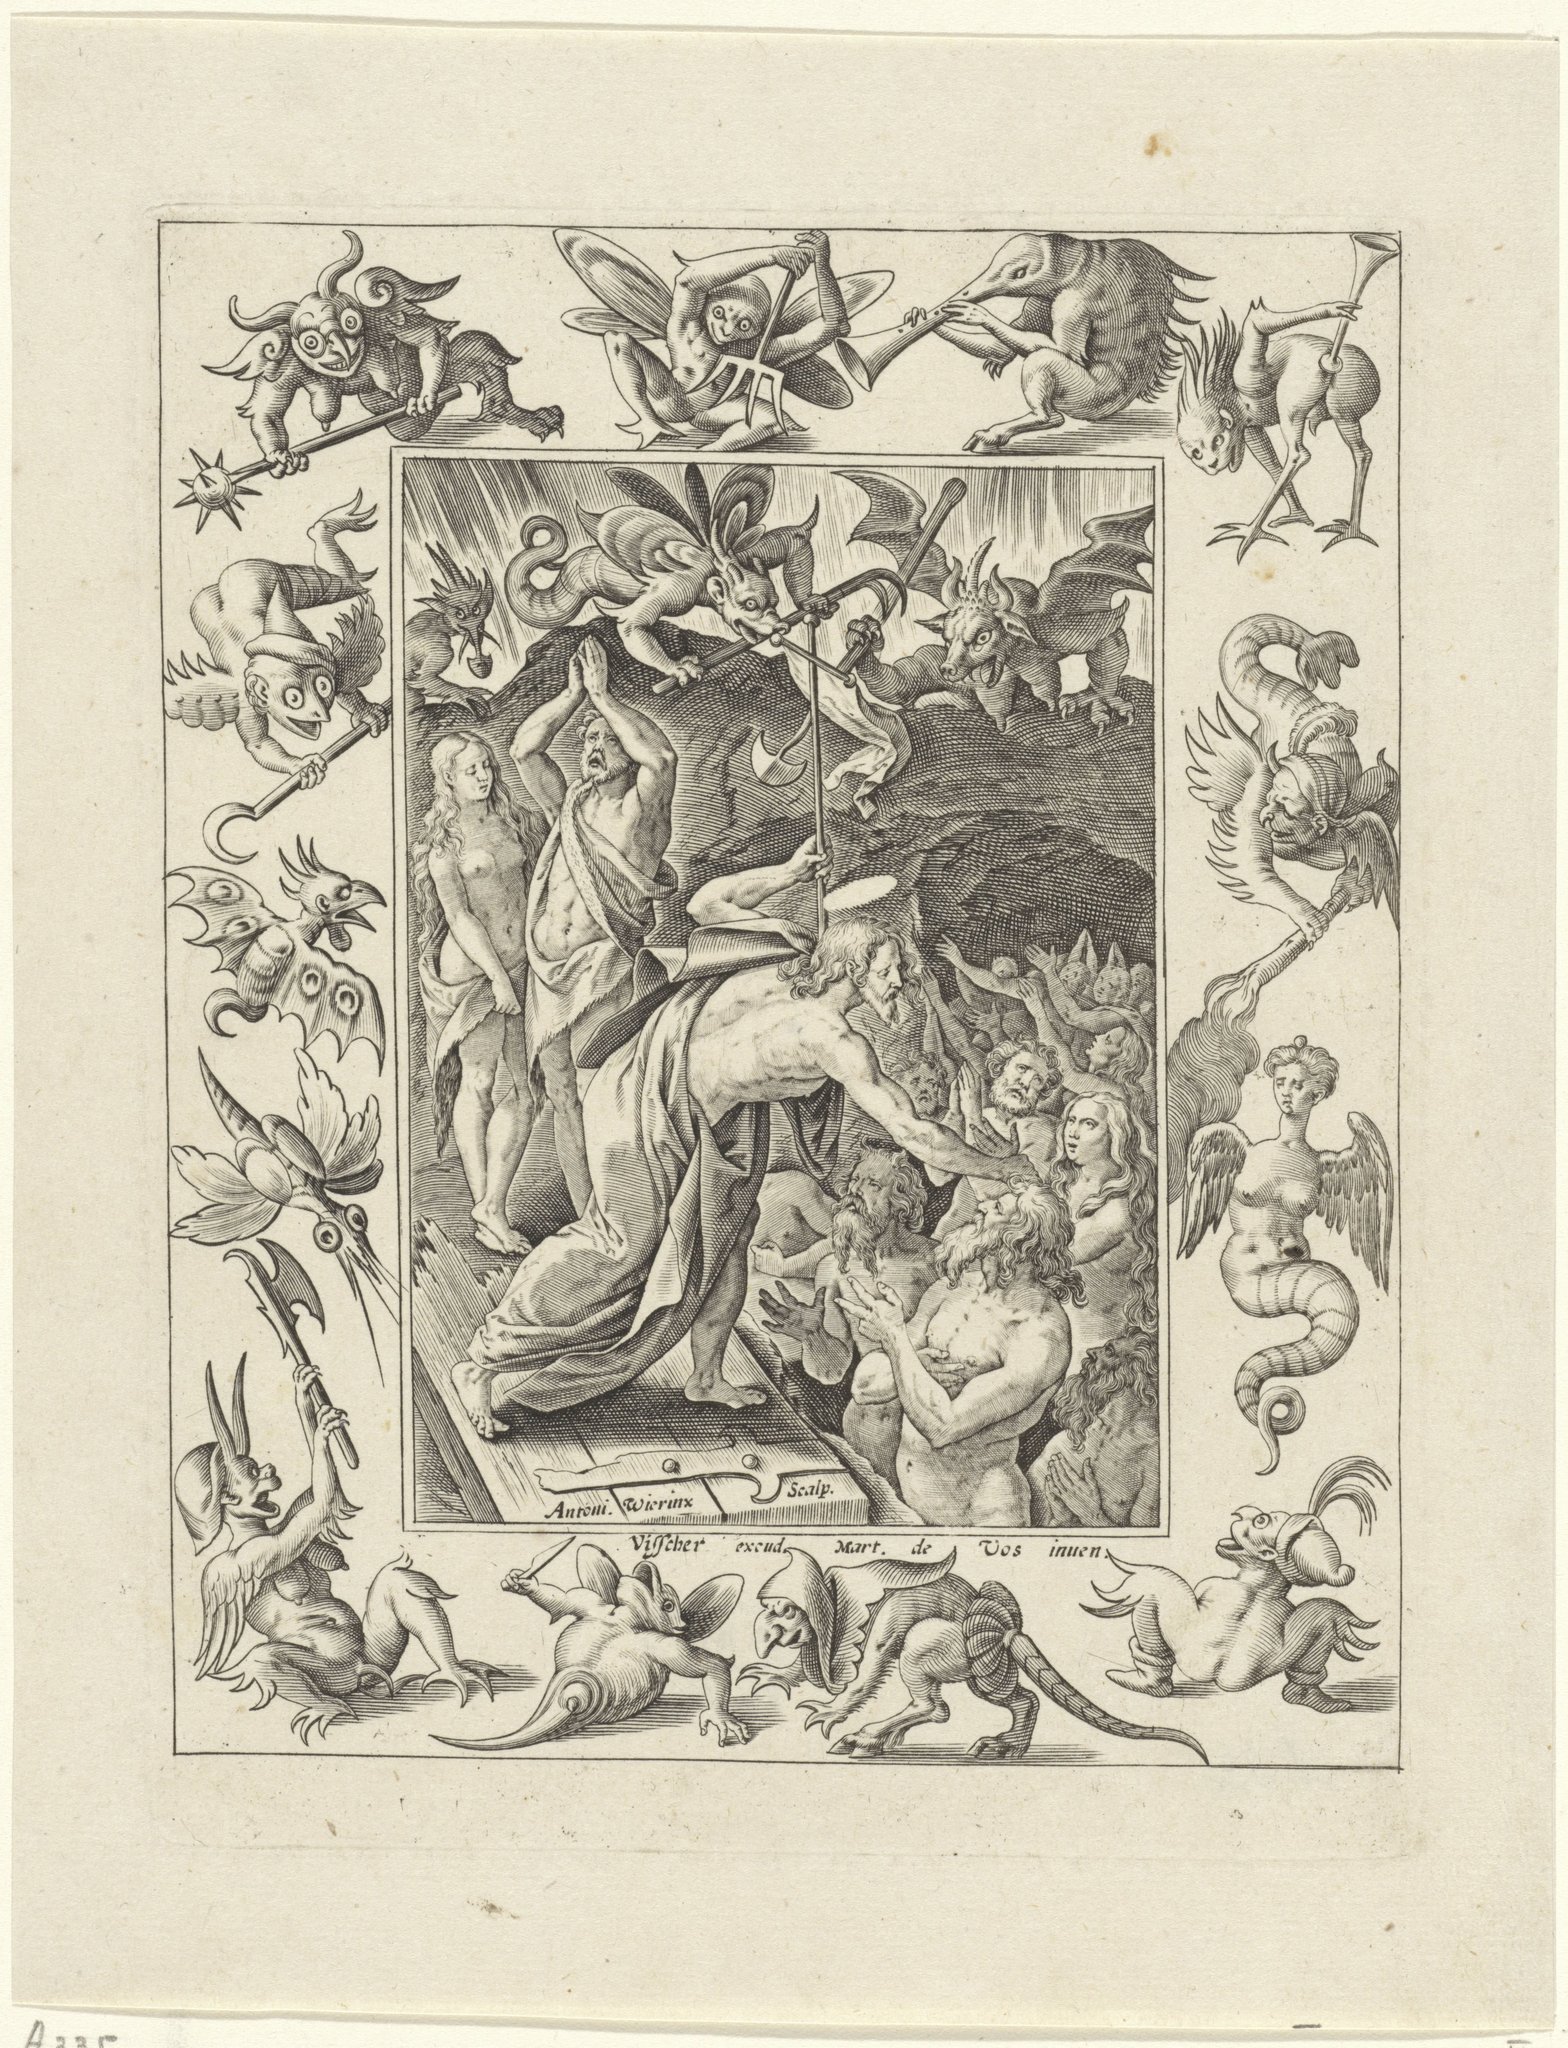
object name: print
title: Passie van Christus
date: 1582-1586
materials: paper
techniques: engraving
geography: amsterdam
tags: christ arrives at the entrance of hell and breaks the door(s), devil(s) and demons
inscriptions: collector's mark: Lugt 2228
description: Na zijn dood daalt Christus af in het voorgeborchte. Bij de poorten van de hel reikt hij de hand aan anonieme figuren. Drie duivels kijken toe. De voorstelling is gevat in een ornamentele omlijsting die is gedecoreerd met verschillende duivels.